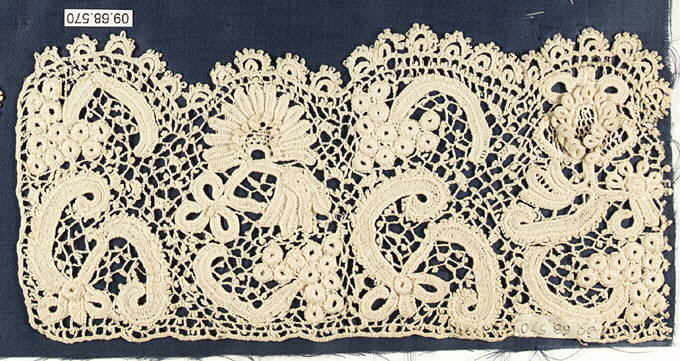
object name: specimen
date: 1801-1900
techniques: crochet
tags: flowers